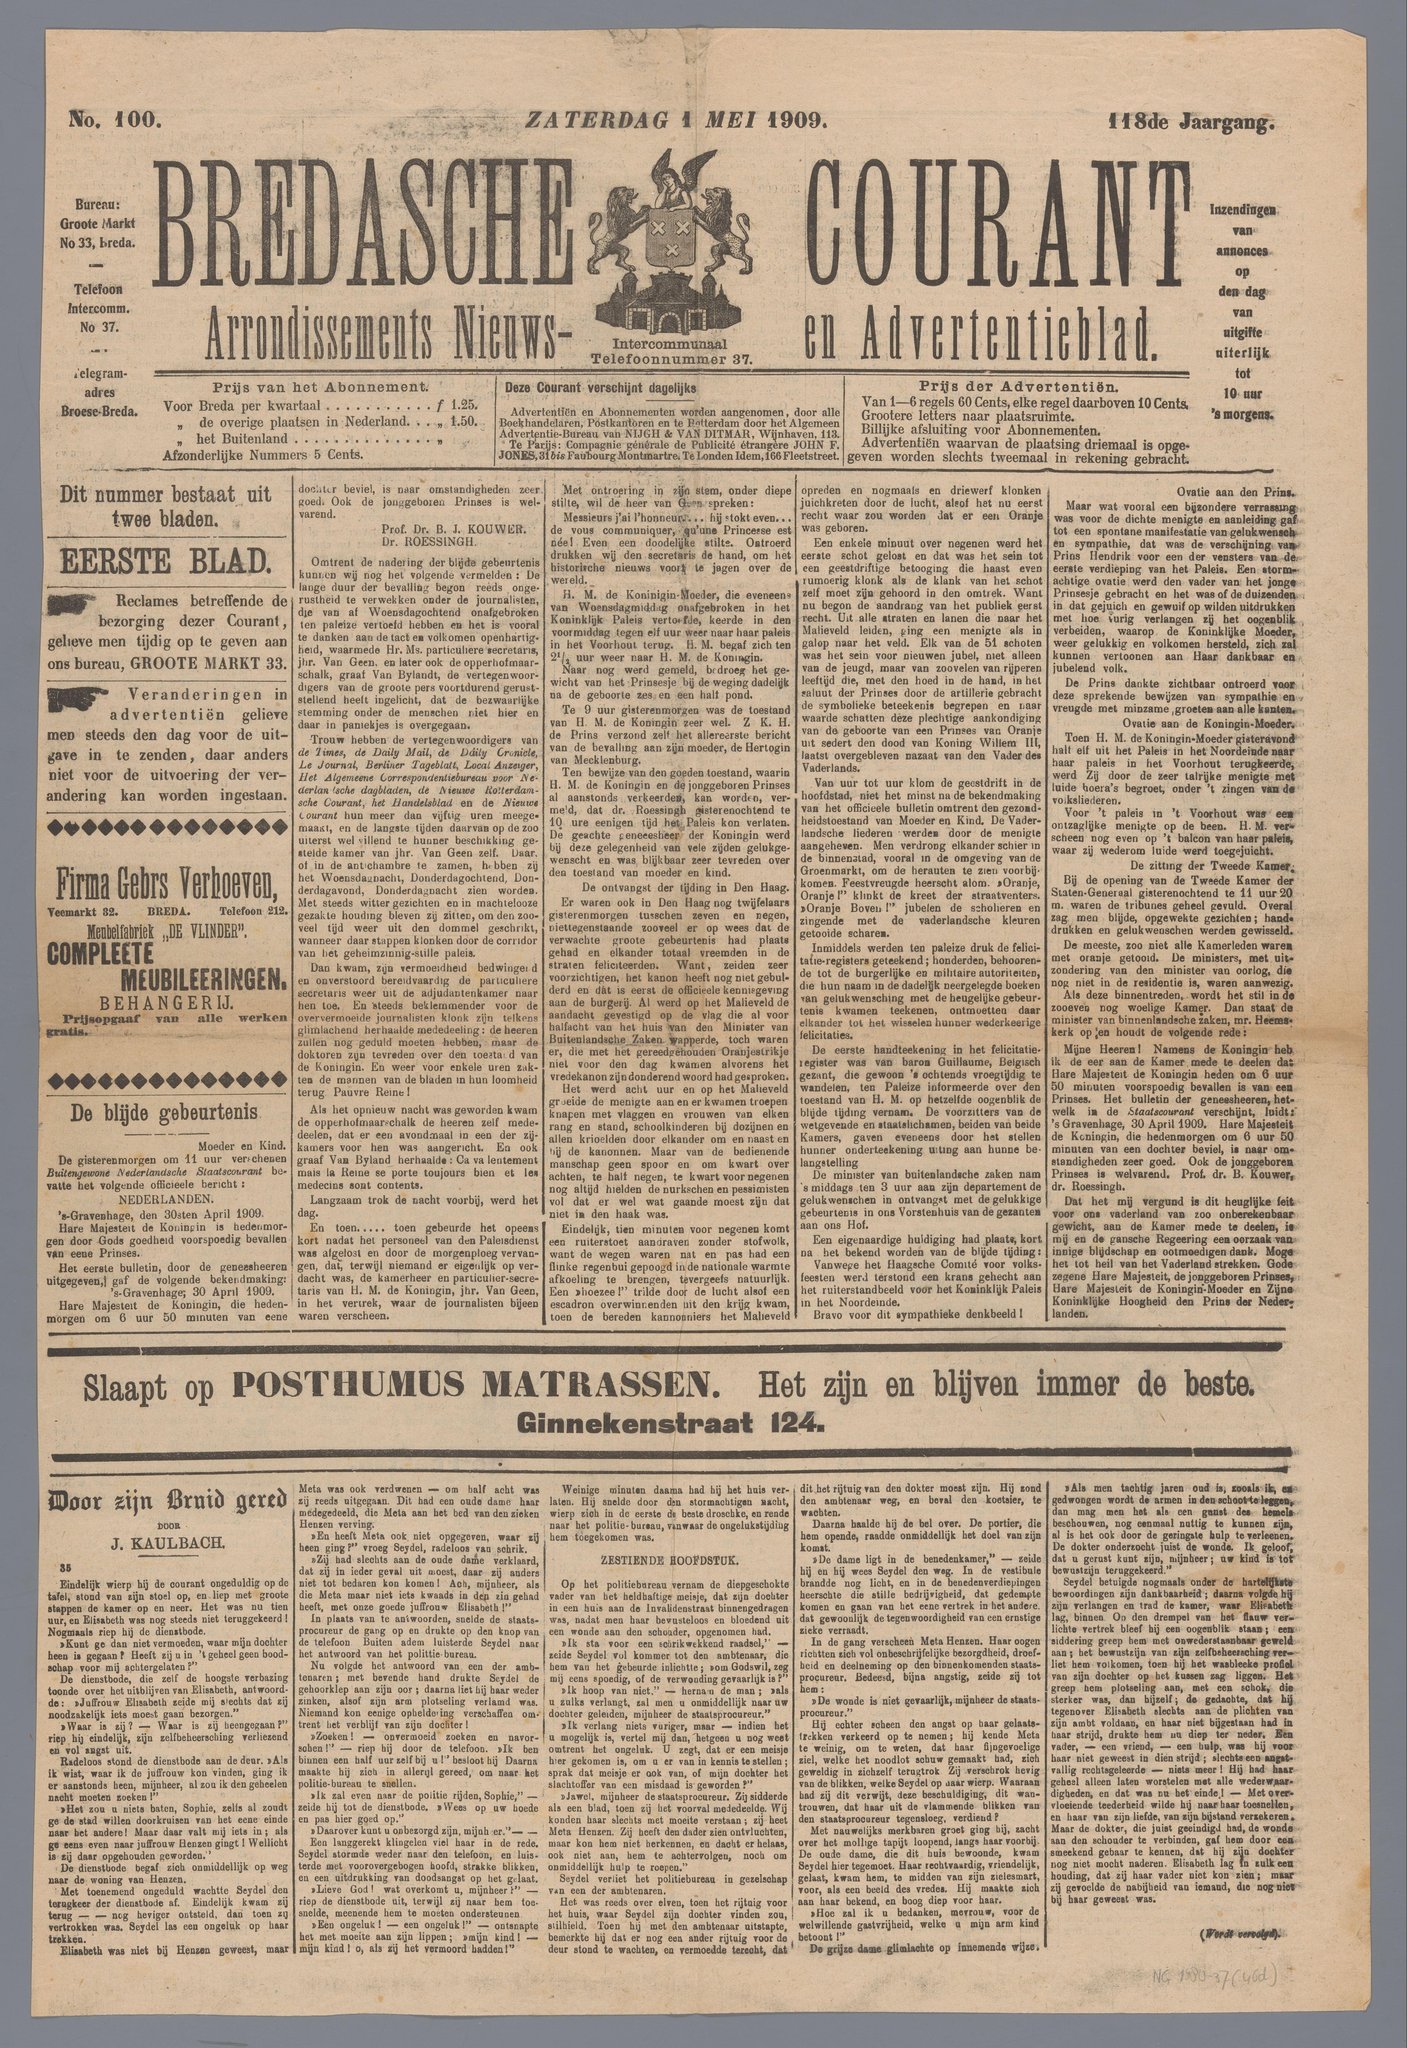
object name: newspaper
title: Bredasche Courant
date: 1909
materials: paper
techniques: printing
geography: breda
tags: the hague, juliana of the netherlands, netherlands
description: Krant nr. 100 van de 118e jaargang van de "Bredasche Courant", 2pp op één blad, over de geboorte van prinses Juliana, 30 april 1909.